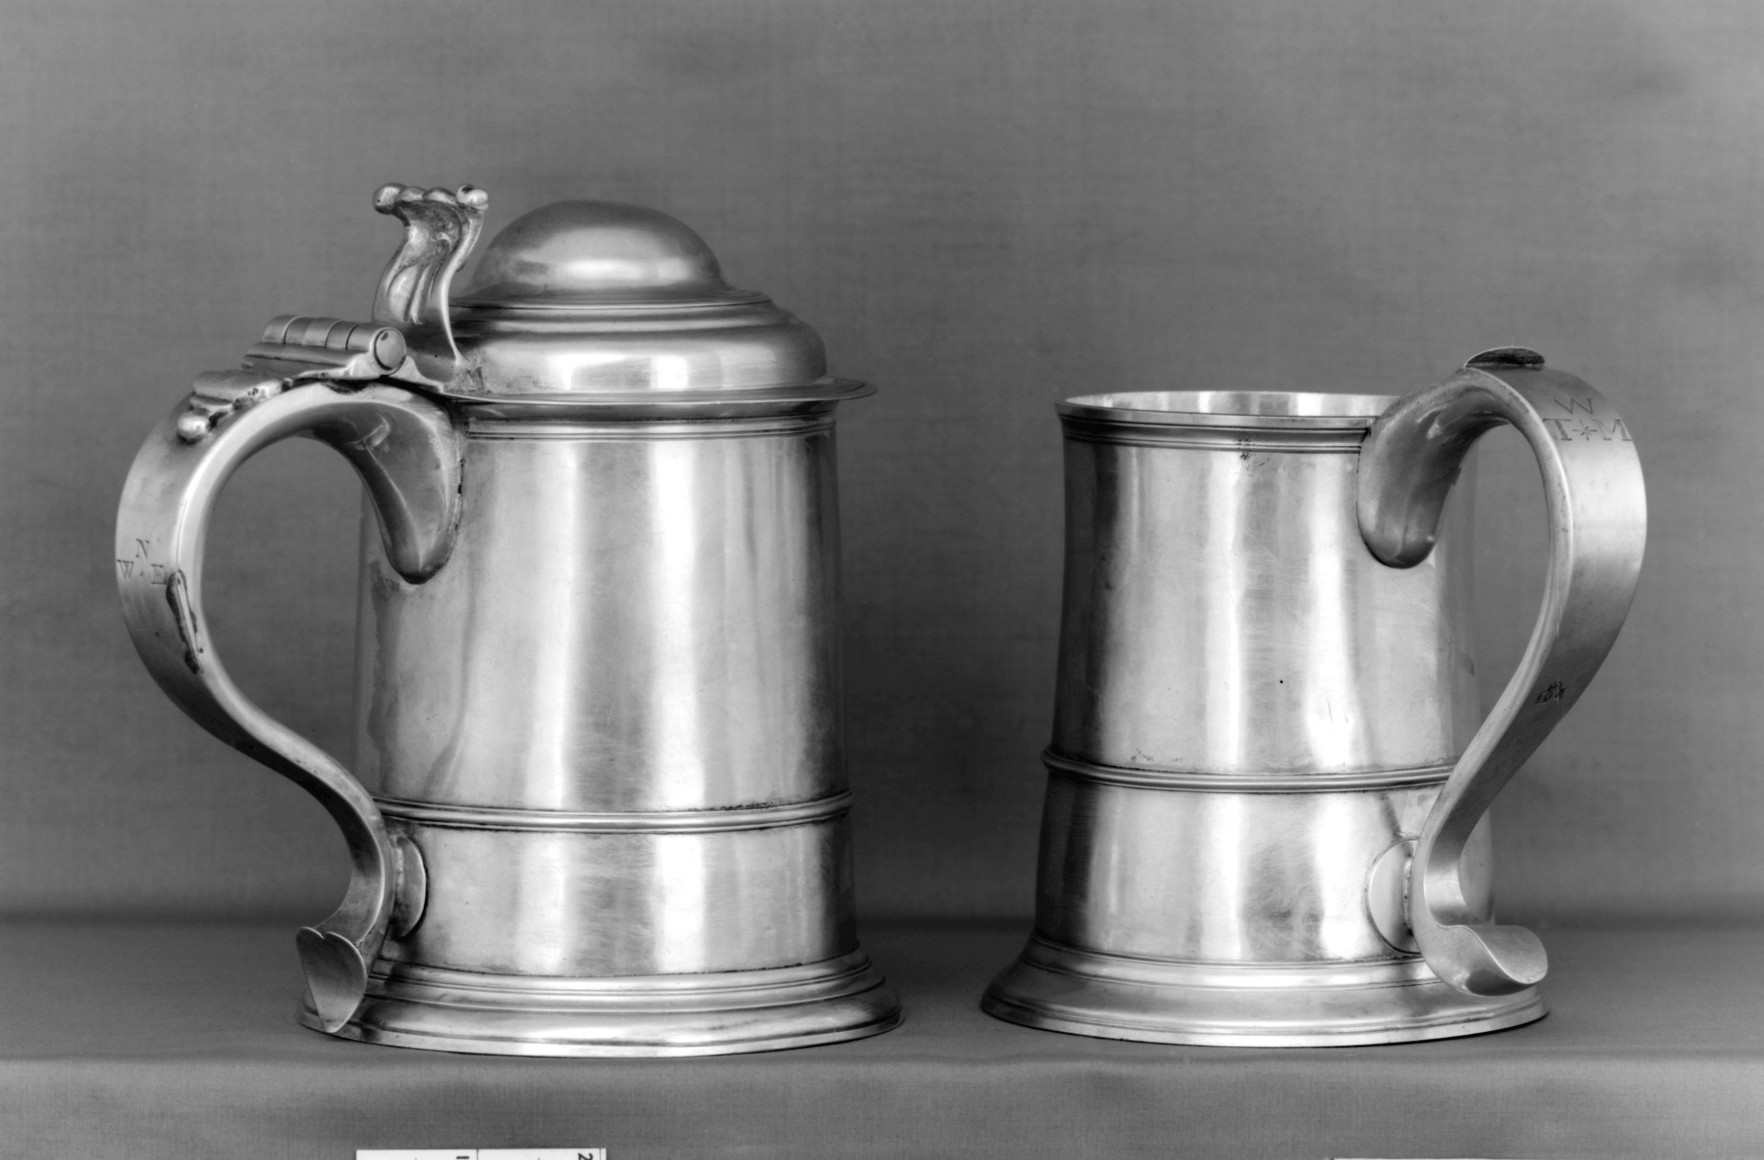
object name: mug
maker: john langlands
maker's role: maker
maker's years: 1725-1825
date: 1770-1771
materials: silver